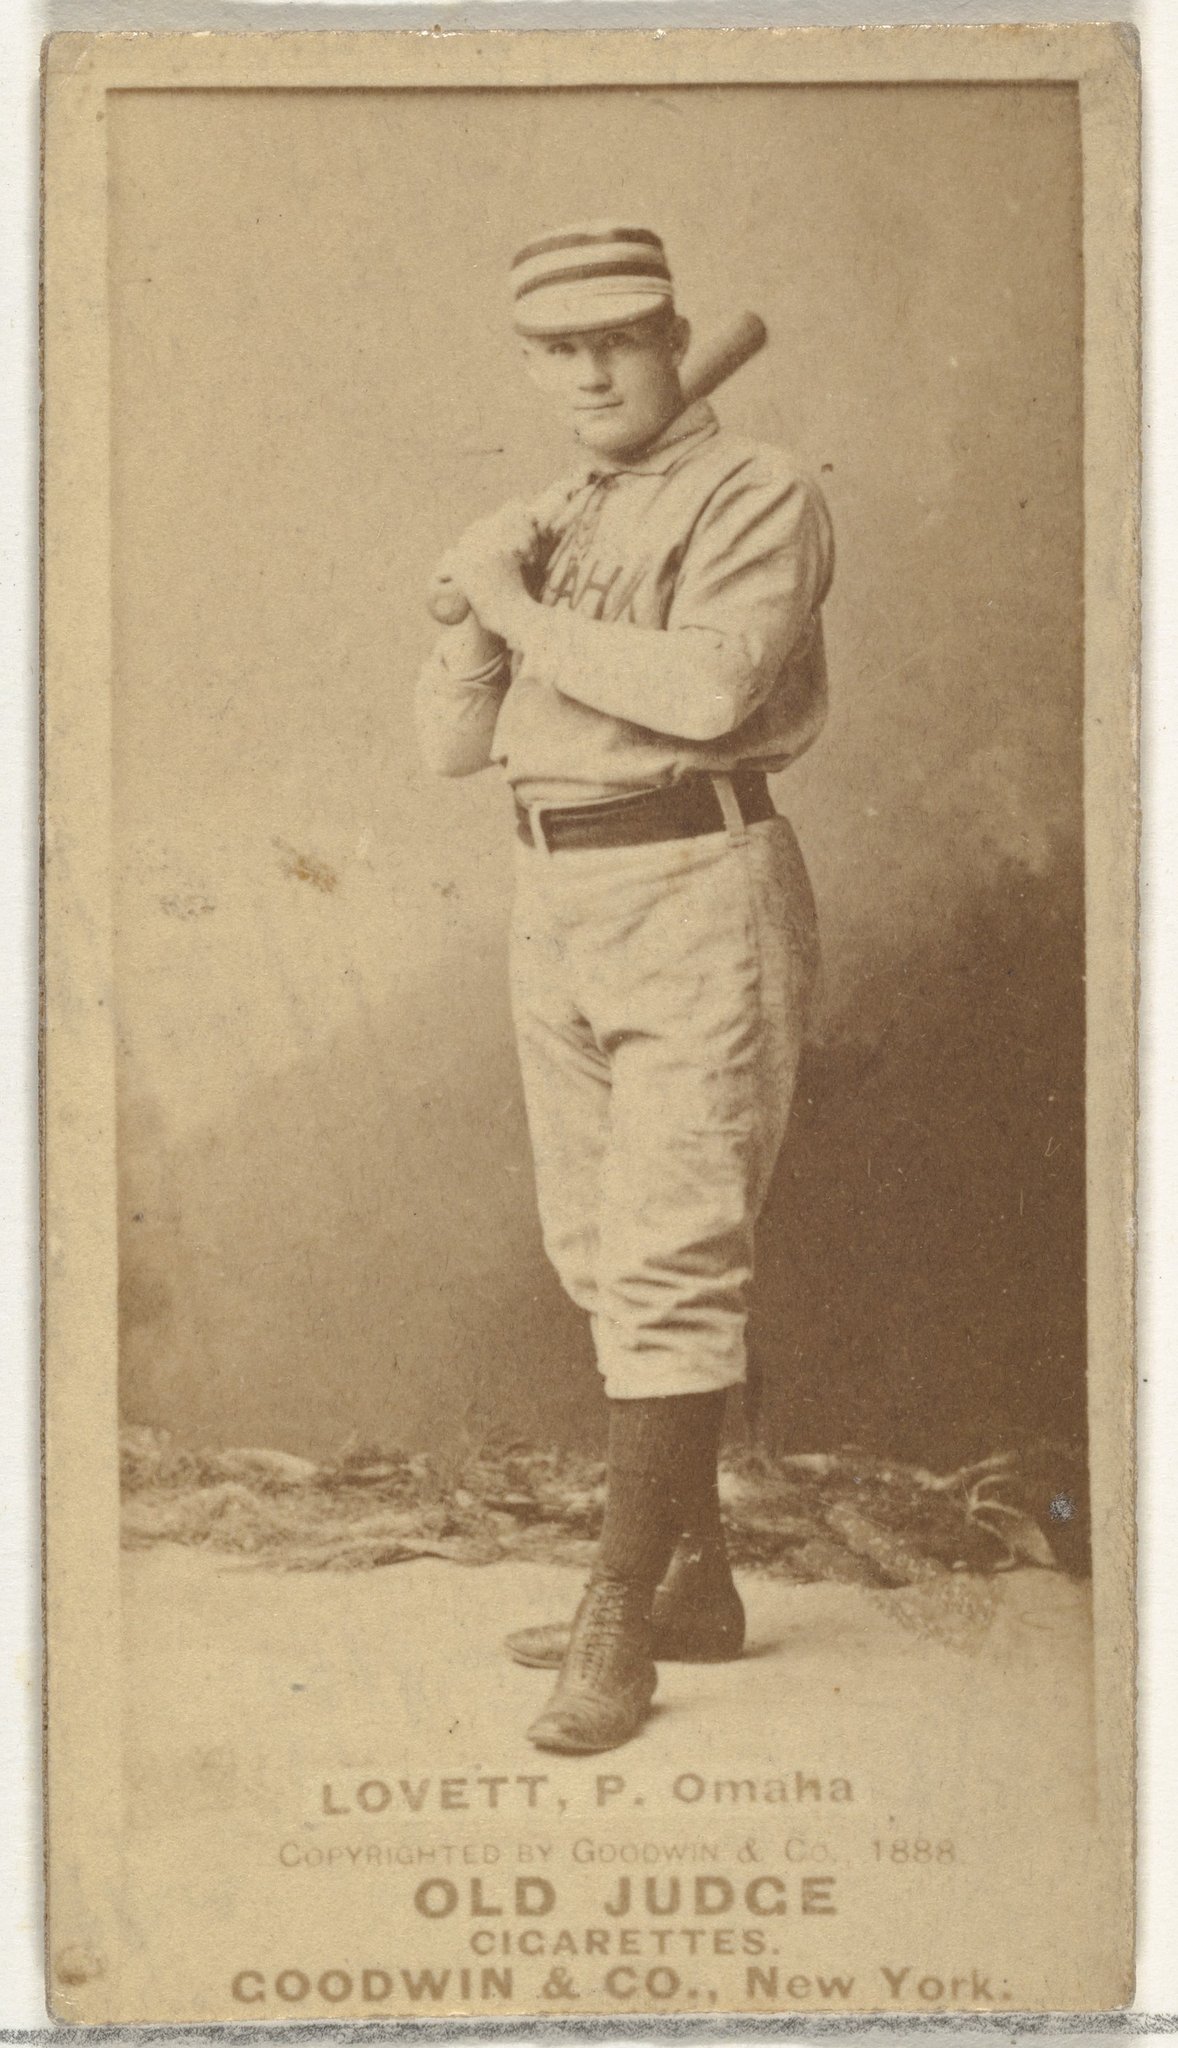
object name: baseball card, photograph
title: Thomas Joseph "Tom" Lovett, Pitcher, Omaha Omahogs/ Lambs, from the Old Judge series (N172) for Old Judge Cigarettes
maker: goodwin & company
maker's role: publisher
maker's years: 1850-1950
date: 1888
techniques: albumen silver print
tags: men,portraits,baseball,athletes